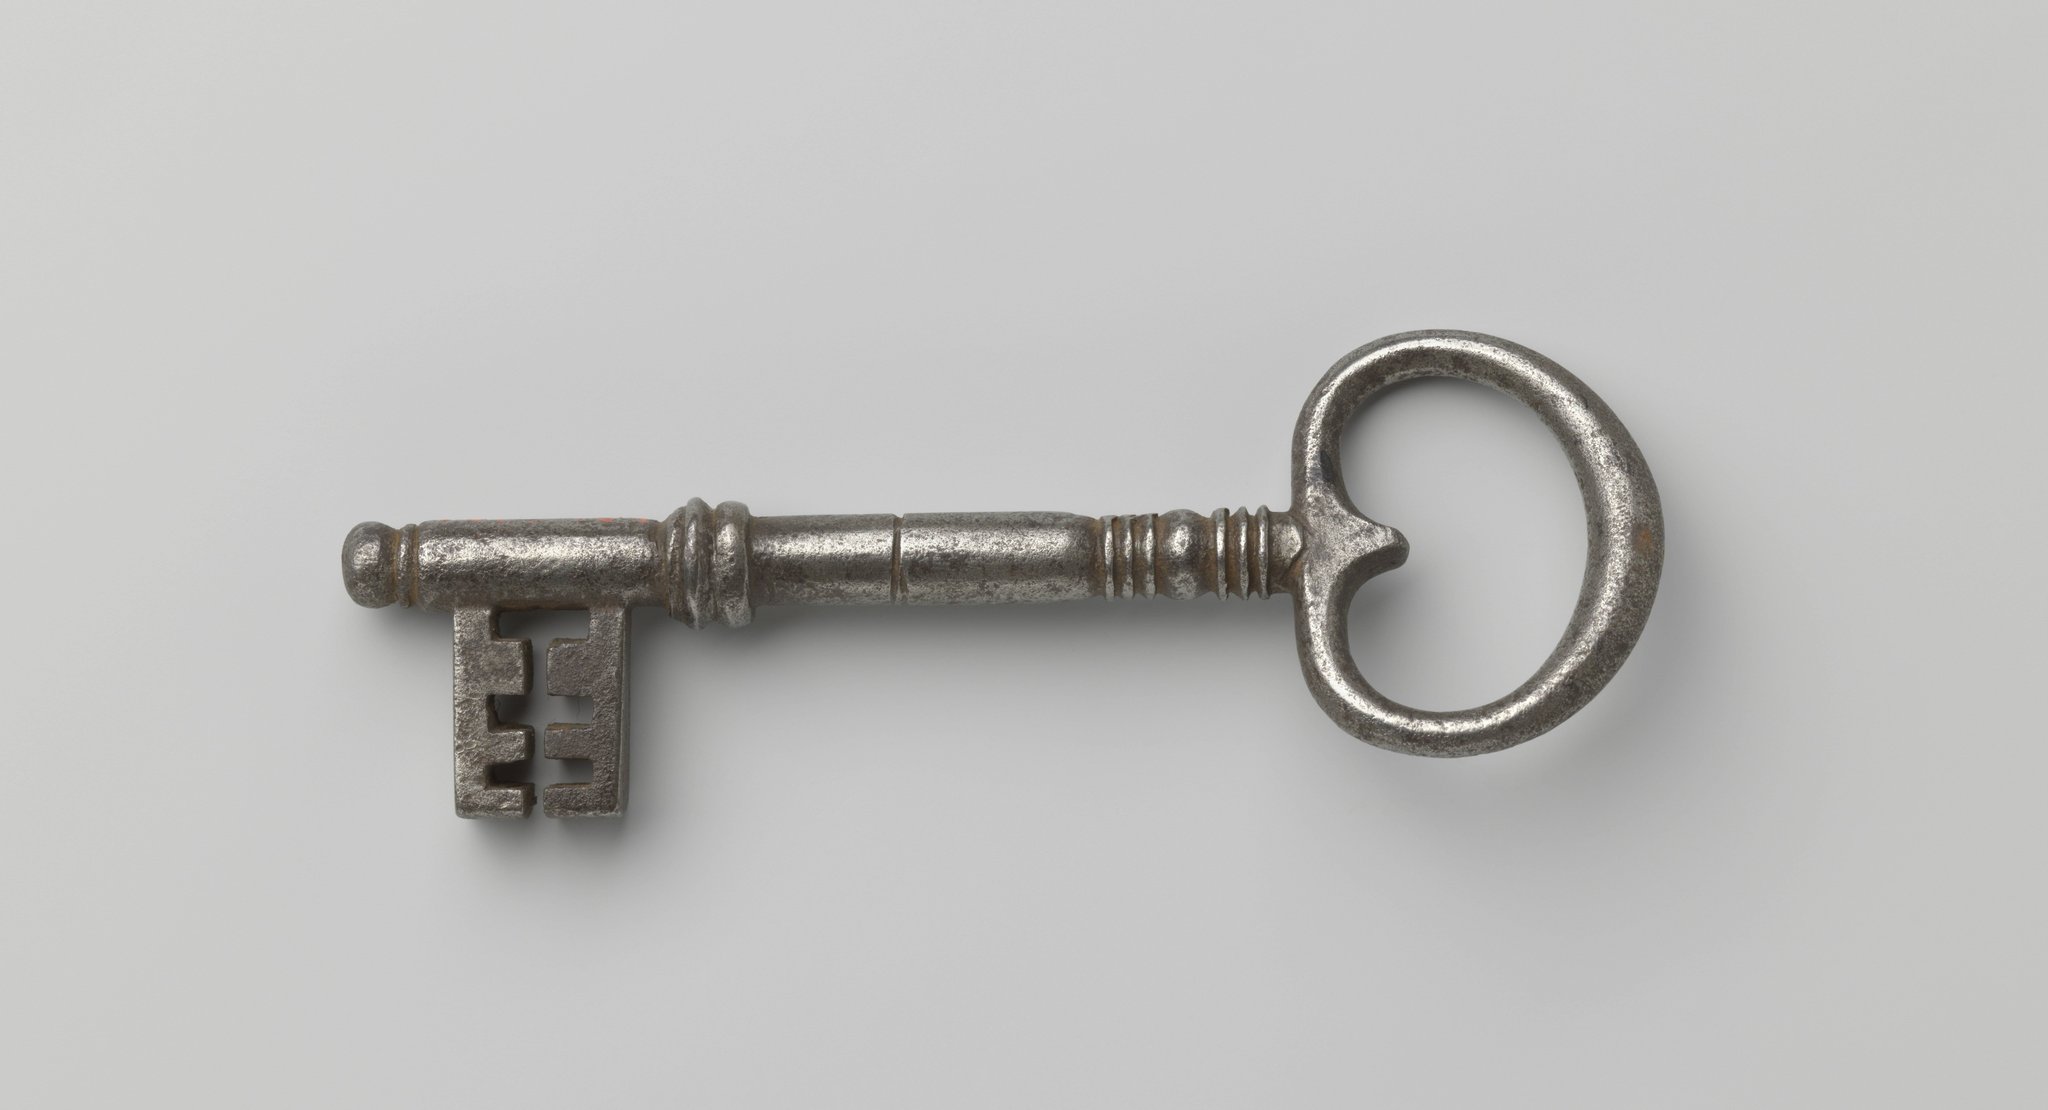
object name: key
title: Sleutel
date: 1600-1699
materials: iron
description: Sleutel met boonvormig oog, geprofileerde schacht die onder de baard in een knopje eindigt. De sleutelborst bevindt zich vlak boven de baard.